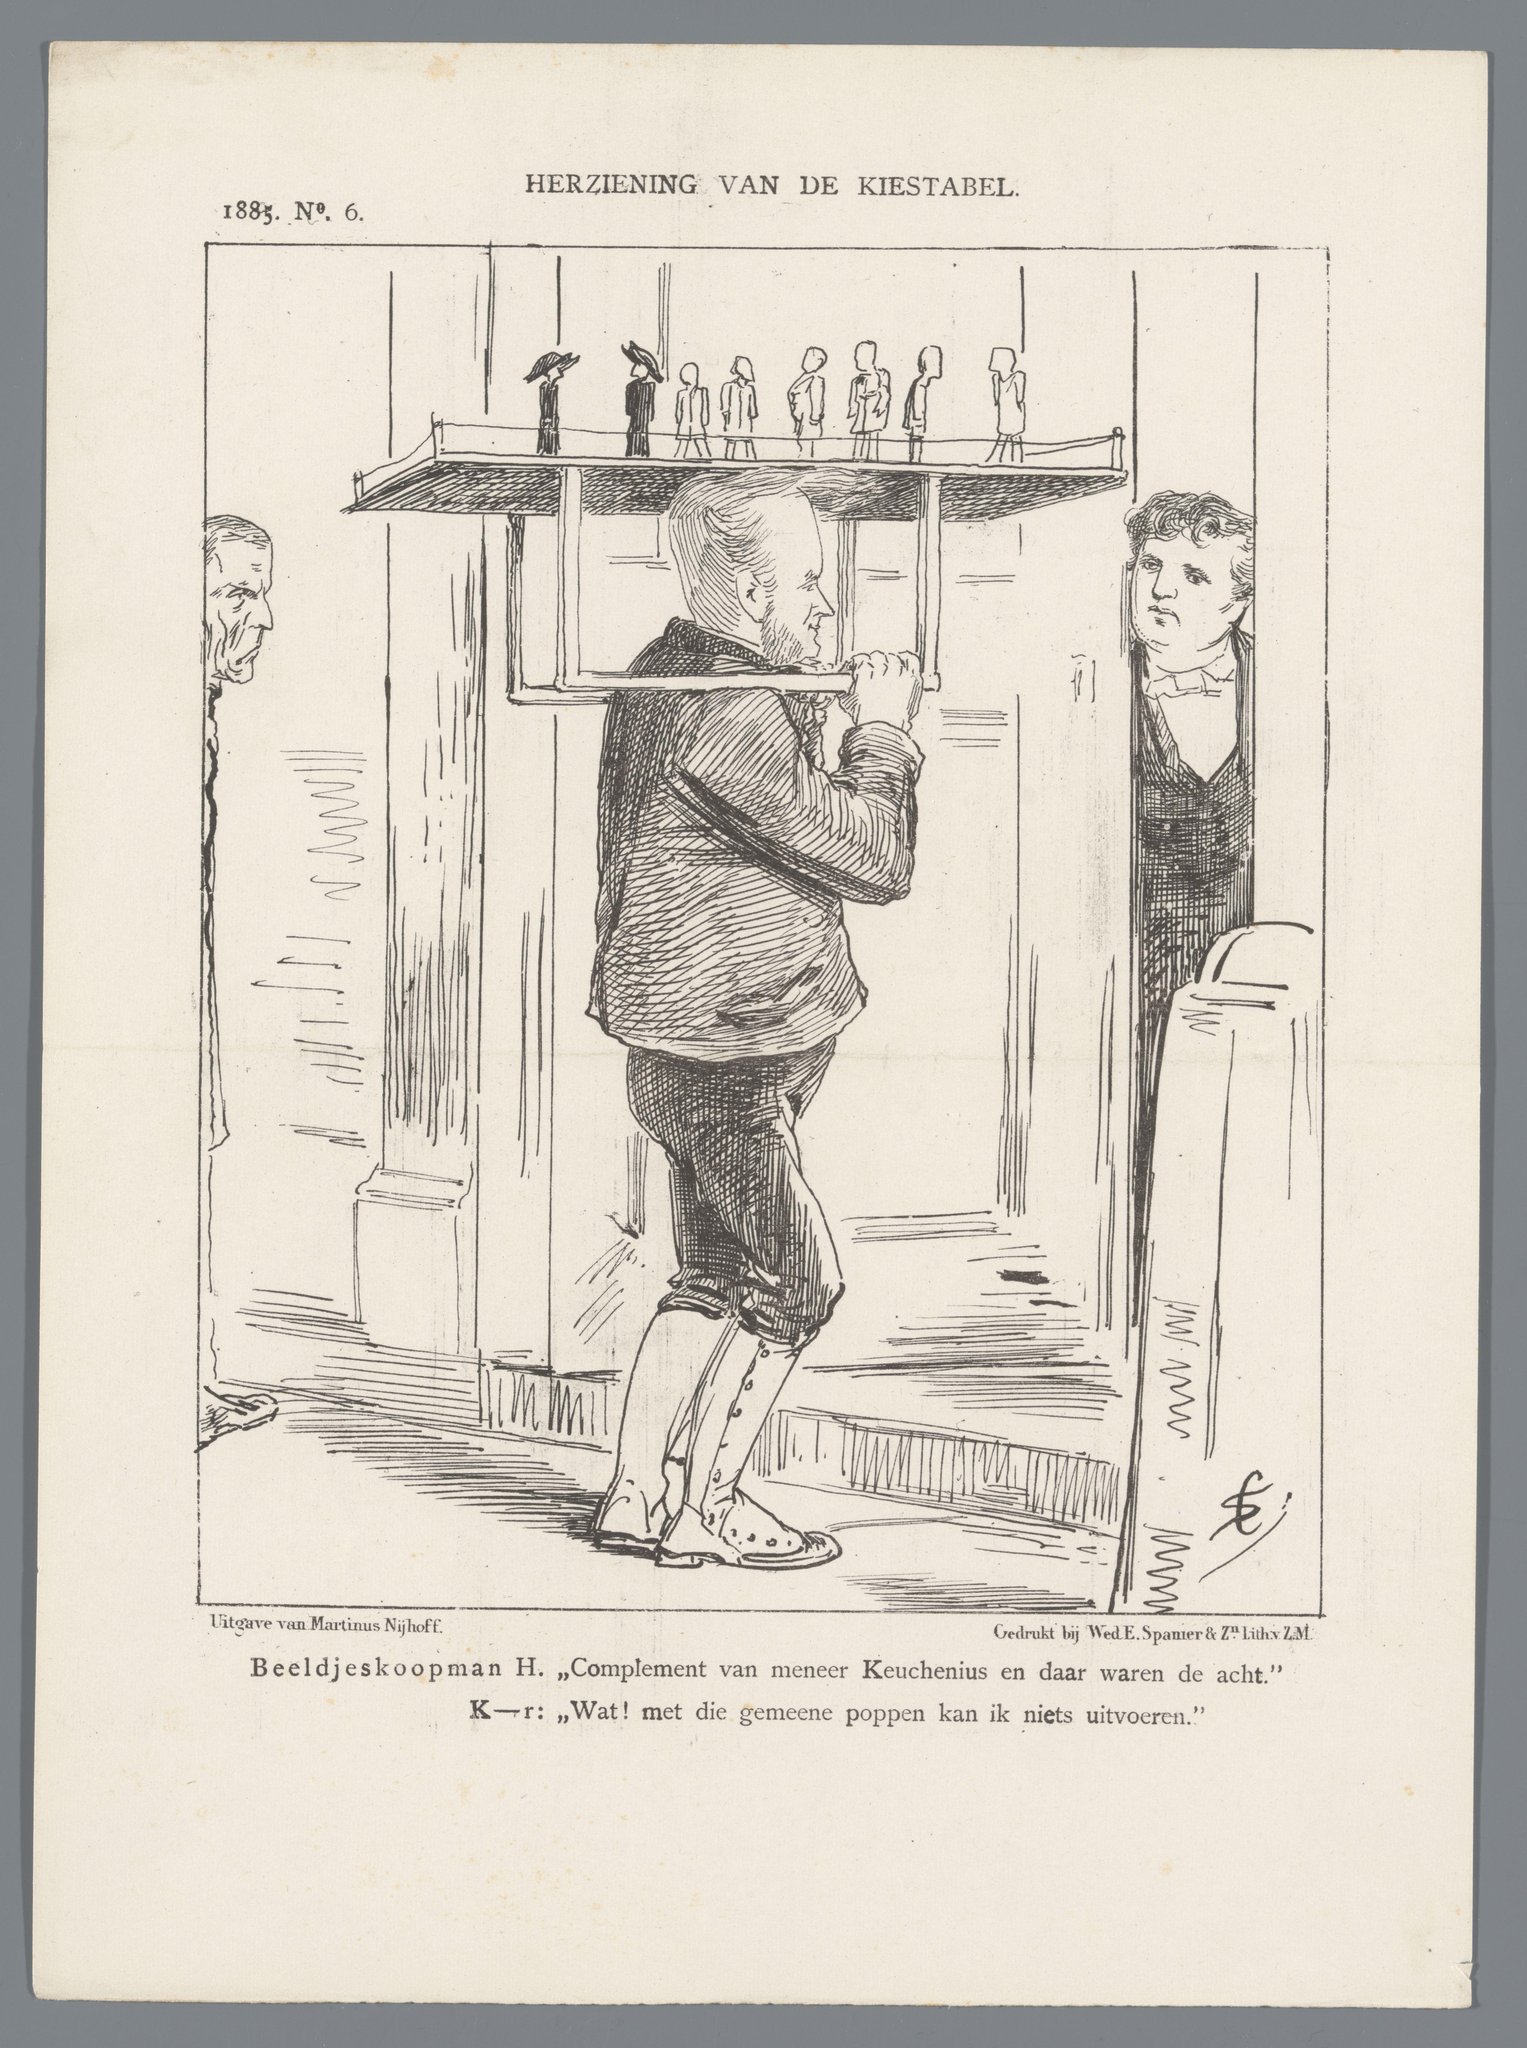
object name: cartoon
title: Spotprent op herziening van de kiestabel, 1885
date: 1885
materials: paper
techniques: lithograph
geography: netherlands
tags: batavia, amsterdam, the hague, politician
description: Spotprent op minister Heemskerk, Keuchenius en de herziening van de kiestabel, 1885. Plaat verschenen bij het weekblad De Nederlandsche Spectator, nr. 6, 1885.